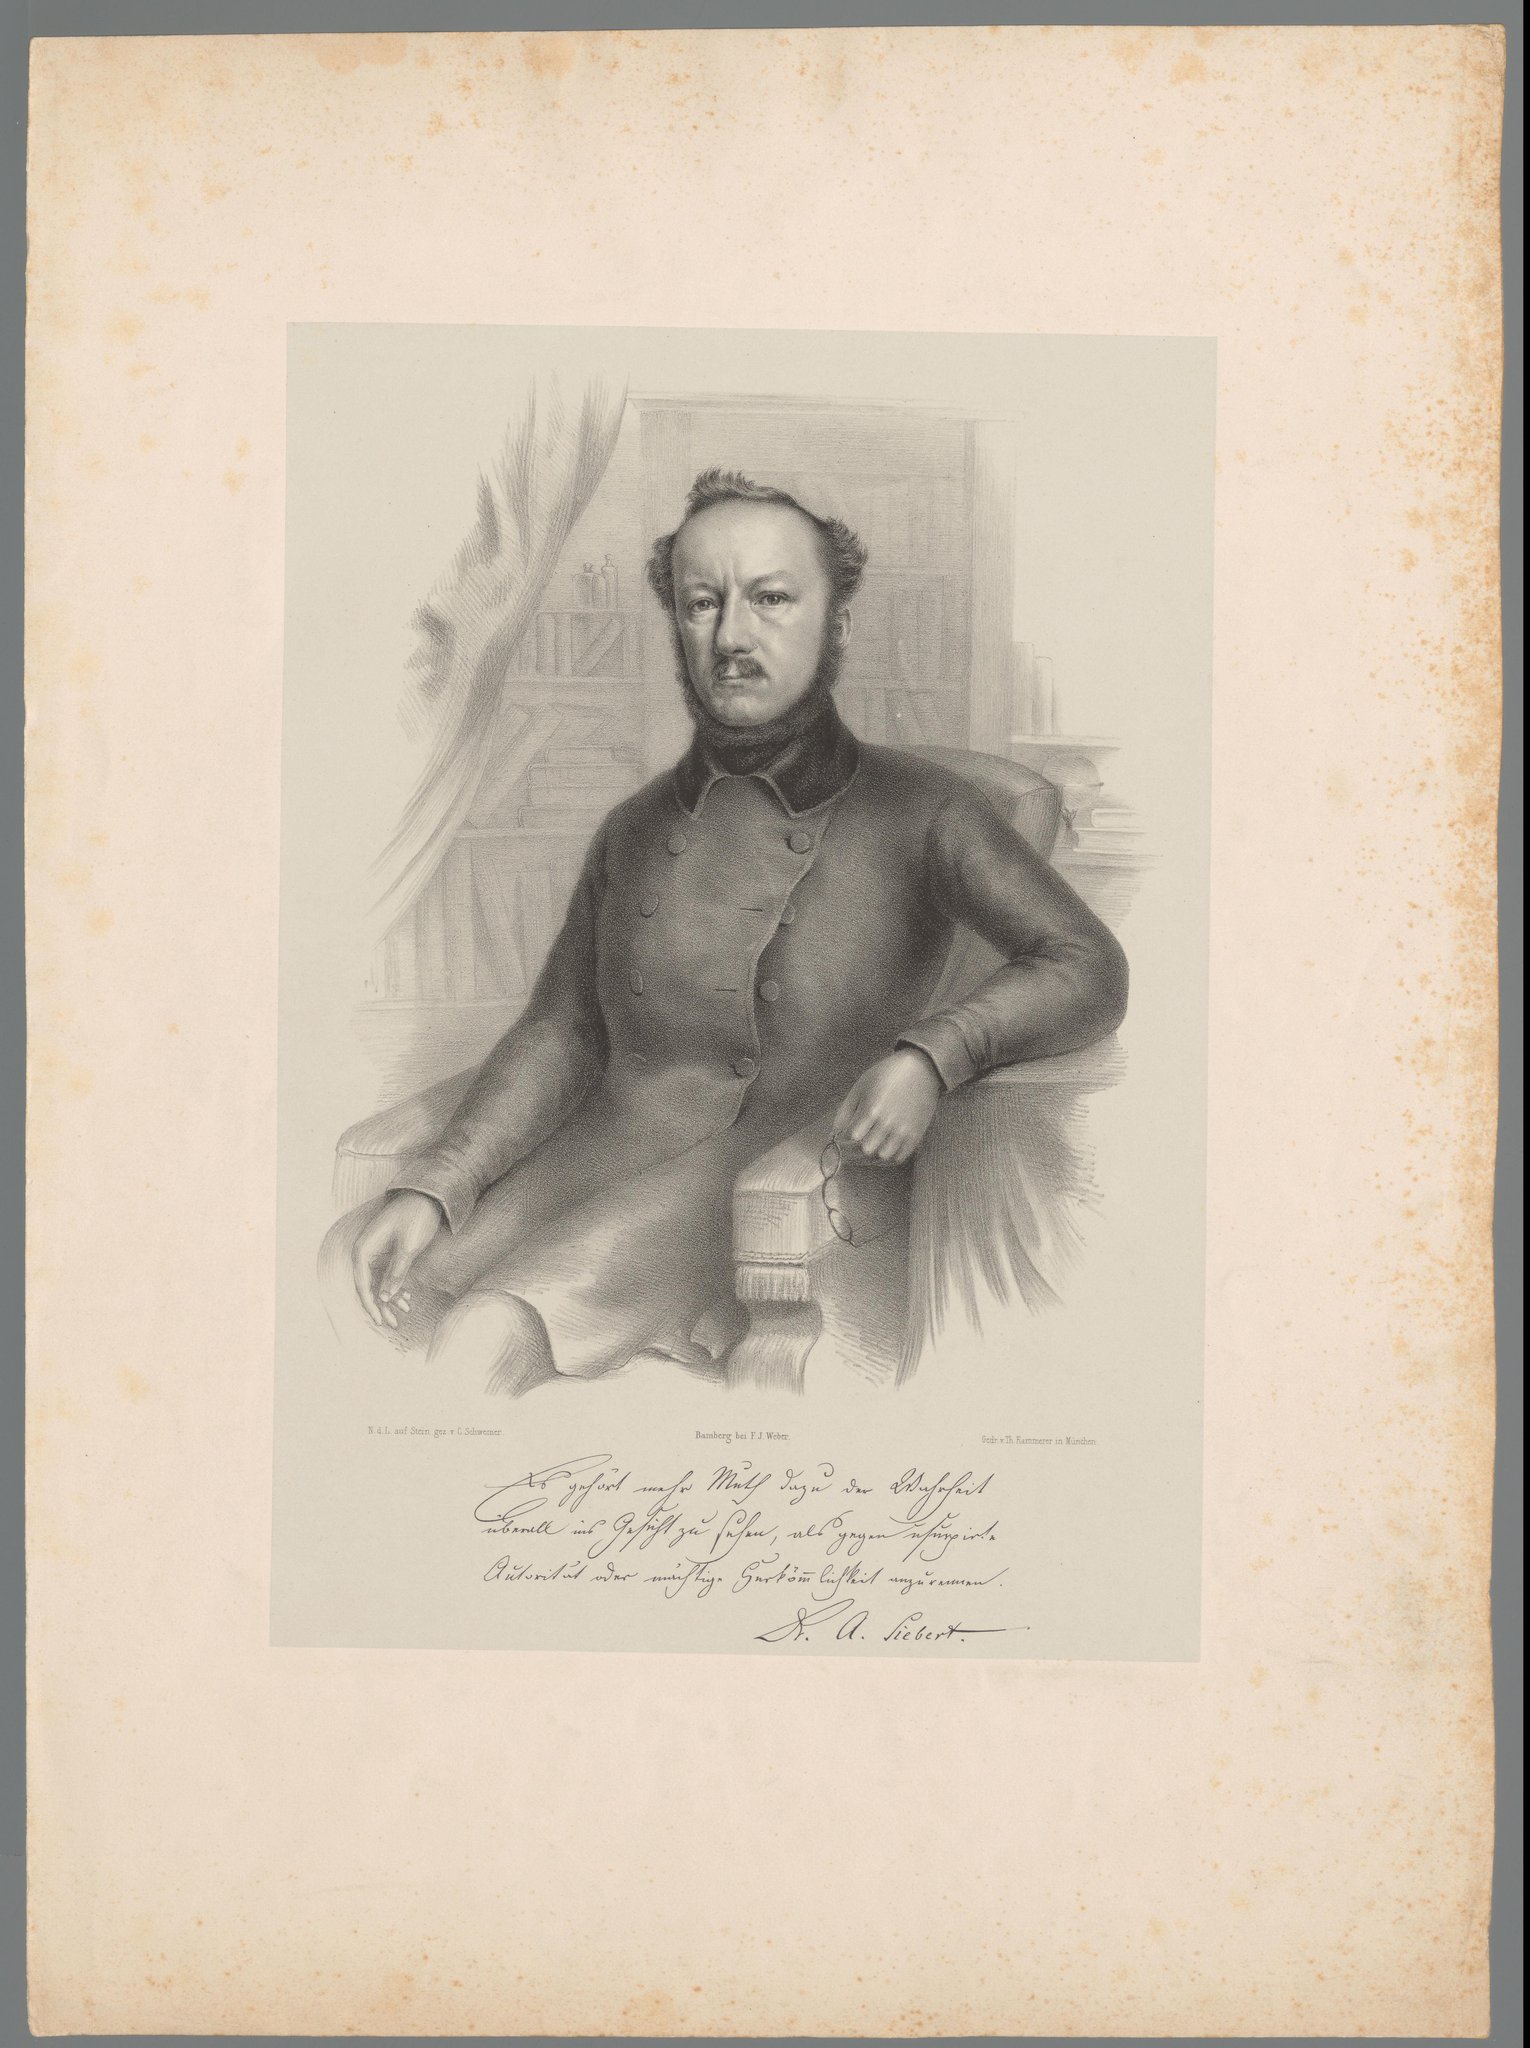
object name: print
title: Portret van een onbekende man, mogelijk A. Siebert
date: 1820-1860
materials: paper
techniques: lithograph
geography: bamberg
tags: eyeglasses, spectacles, adult man, historical persons, study; 'studiolo'; library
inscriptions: collector's mark: Lugt 2228